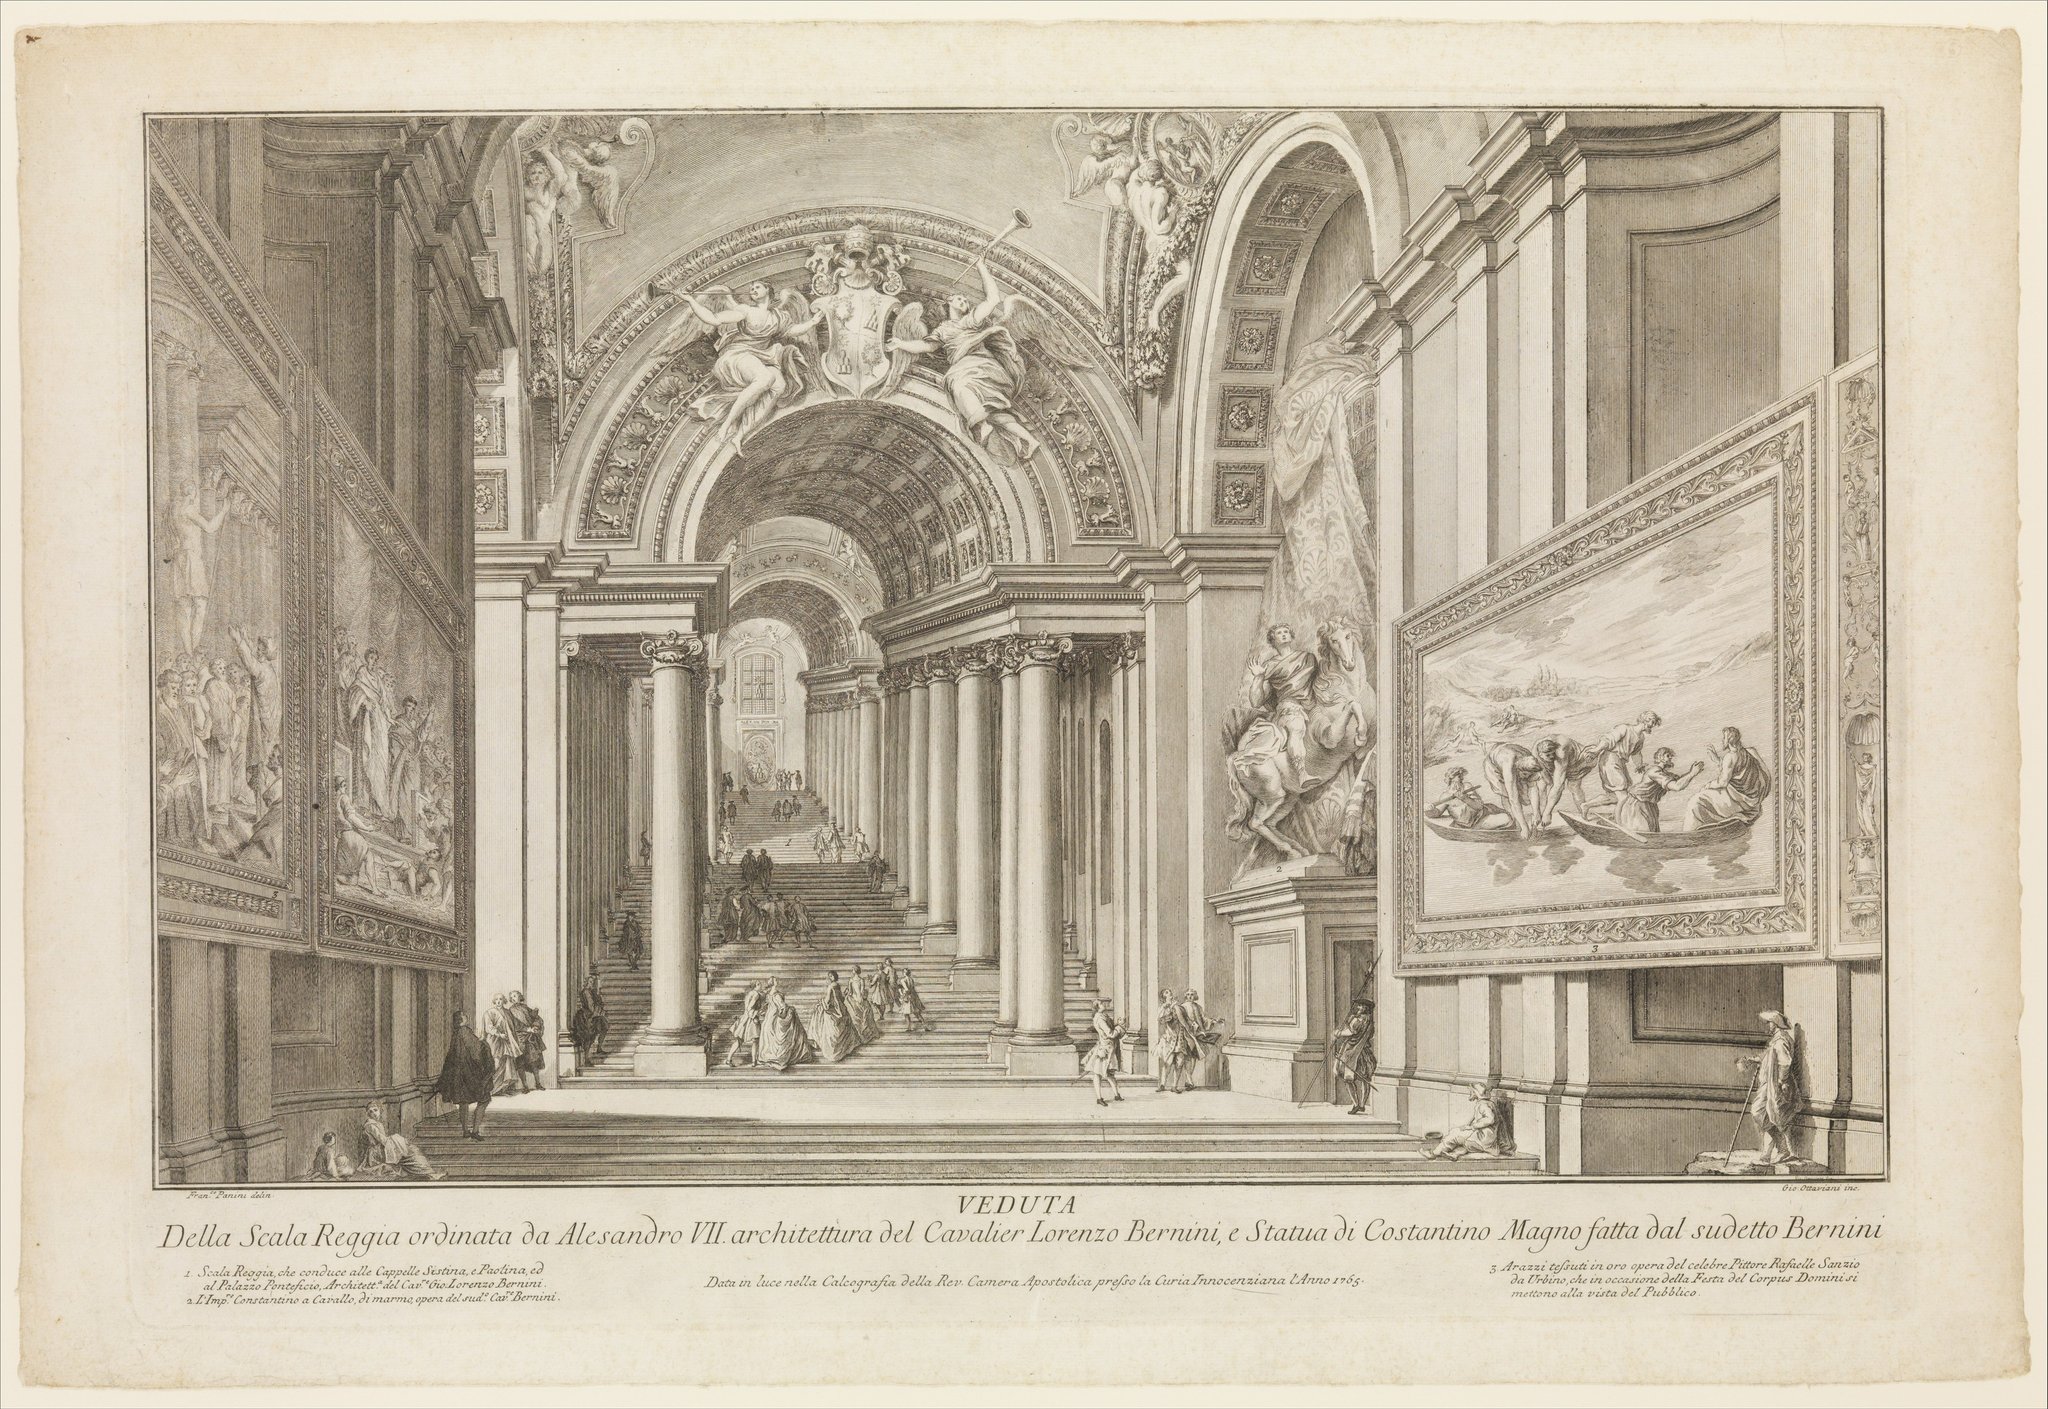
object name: print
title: View of the Scala Reggia ordered by Alesandro VII (Vedute Della Scala Reggia ordinata da Alesandro VII)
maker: giovanni ottaviani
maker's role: artist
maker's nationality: italian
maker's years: 1735-1808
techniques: etching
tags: architecture,arches,stairs